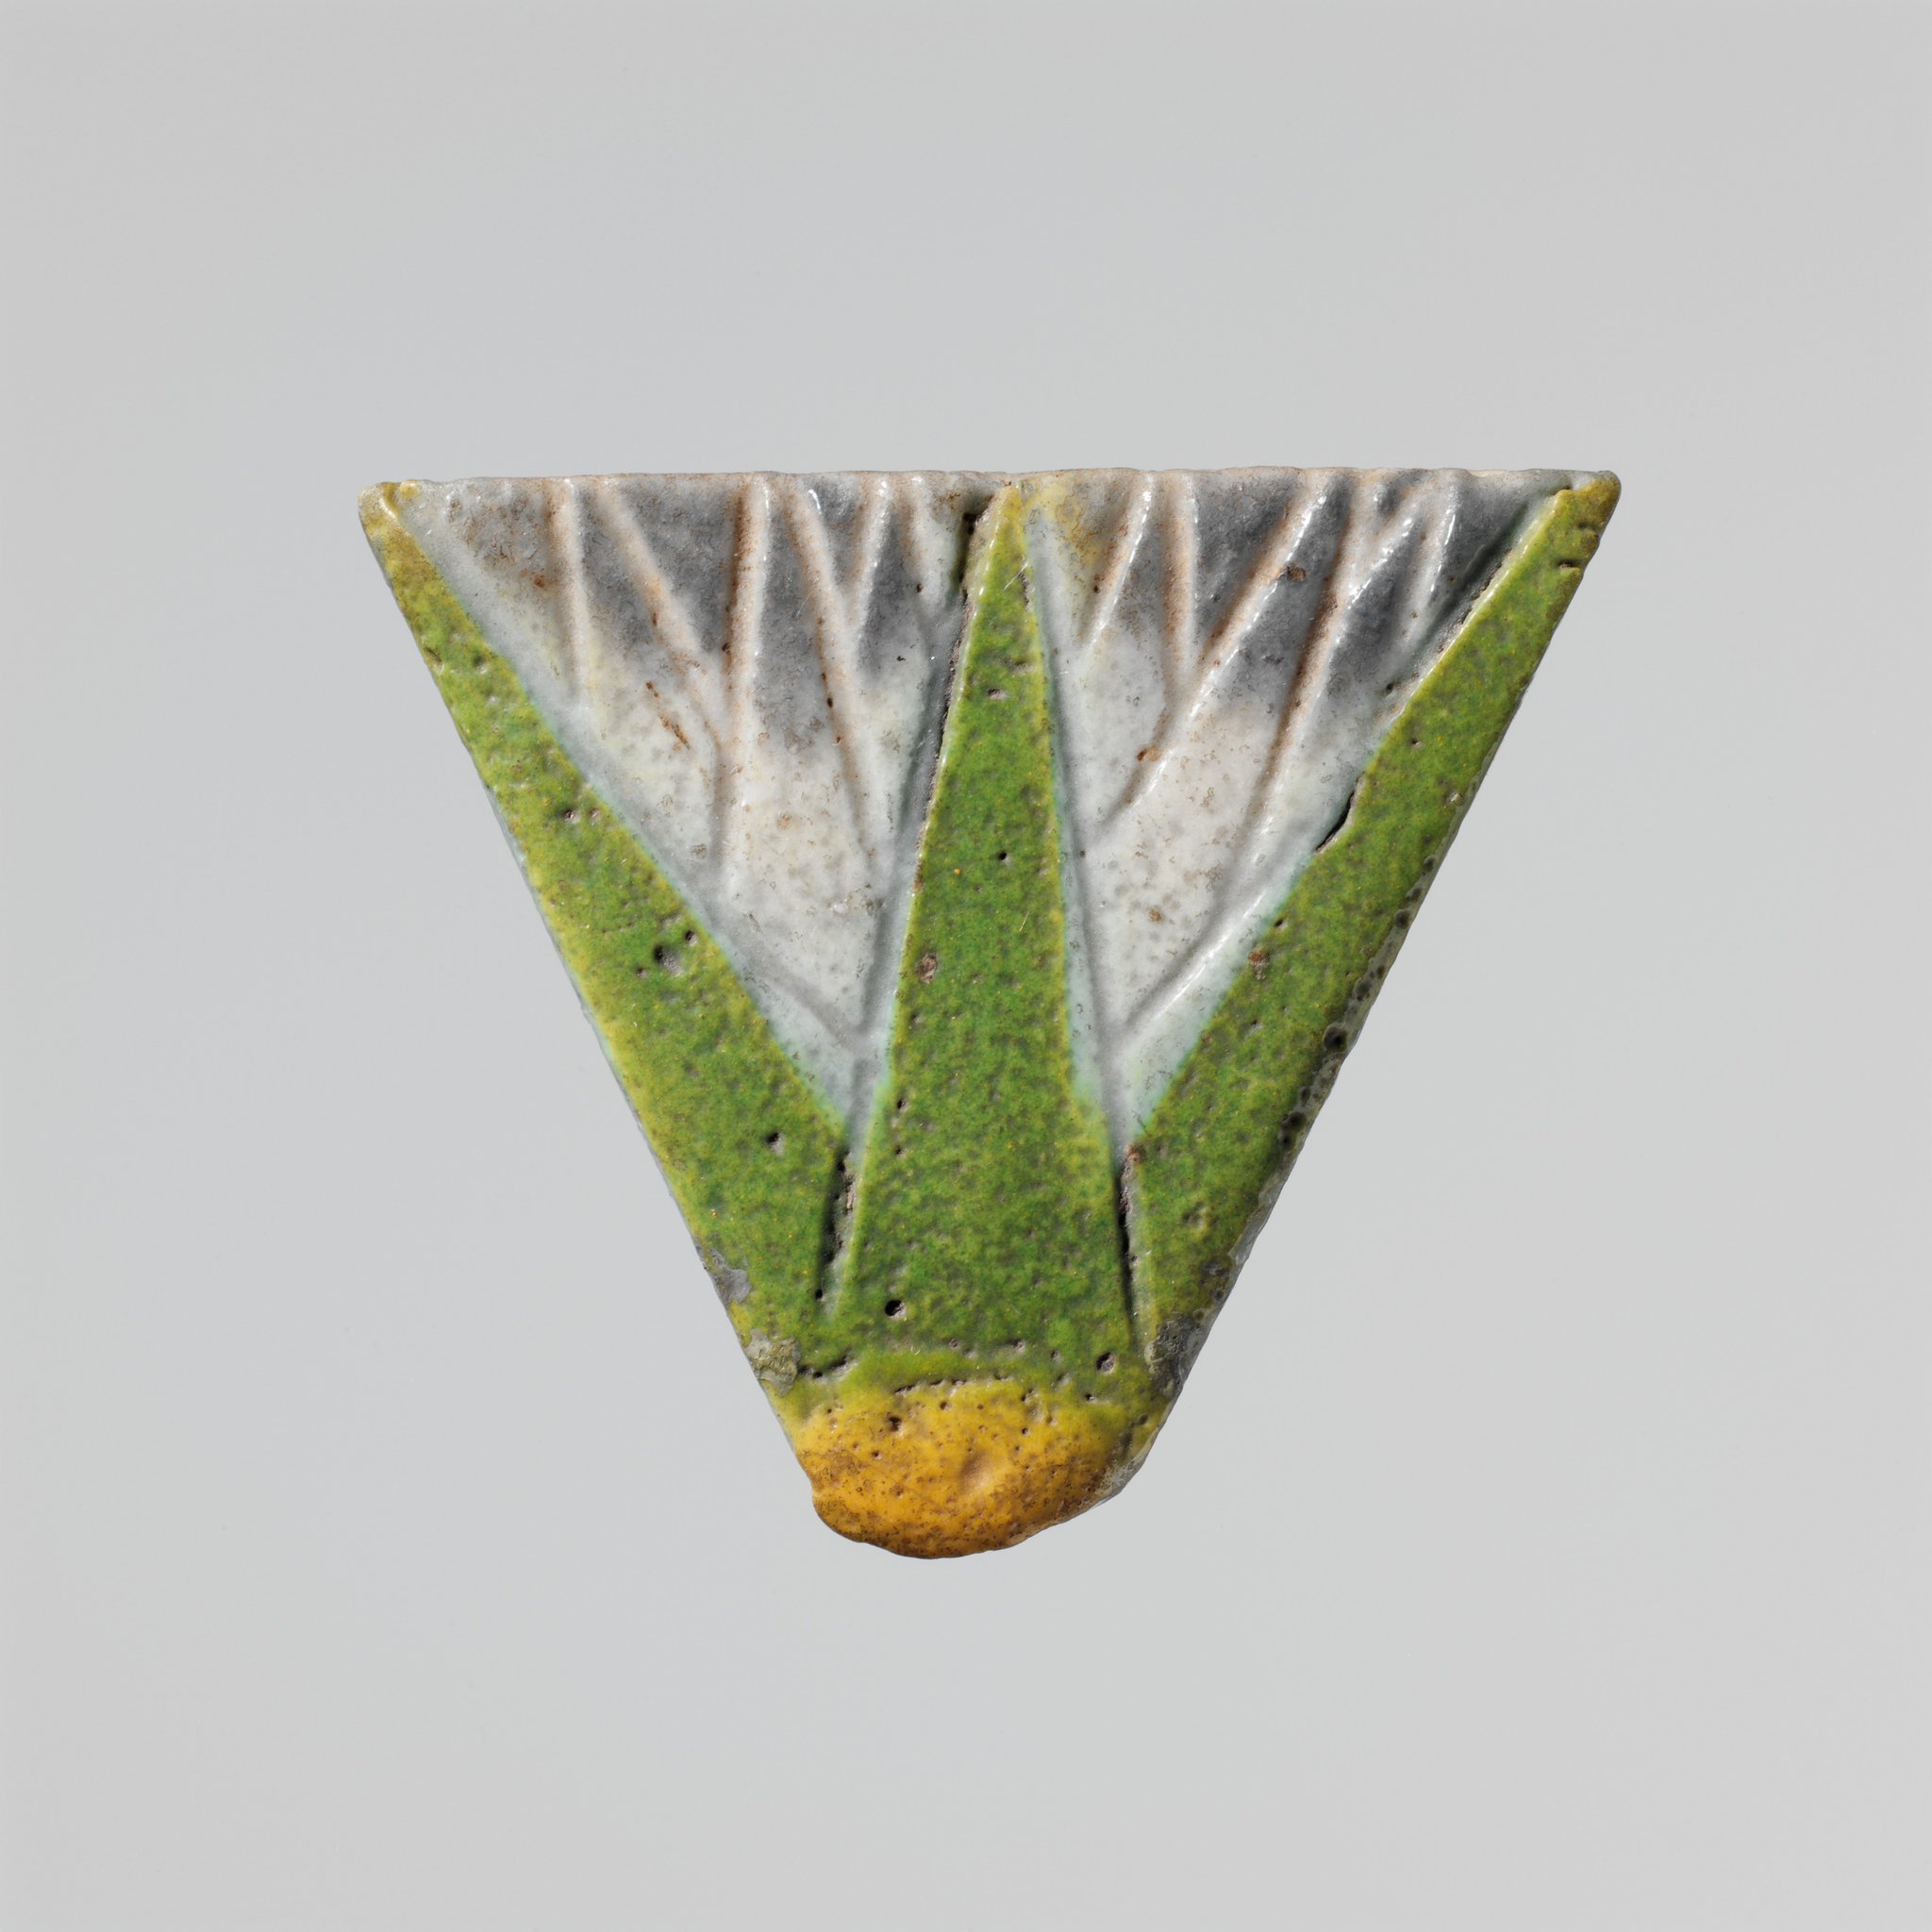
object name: inlay, lotus flower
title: Lotus Flower Inlay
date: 1353-1336 BCE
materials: faience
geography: egypt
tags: lotuses